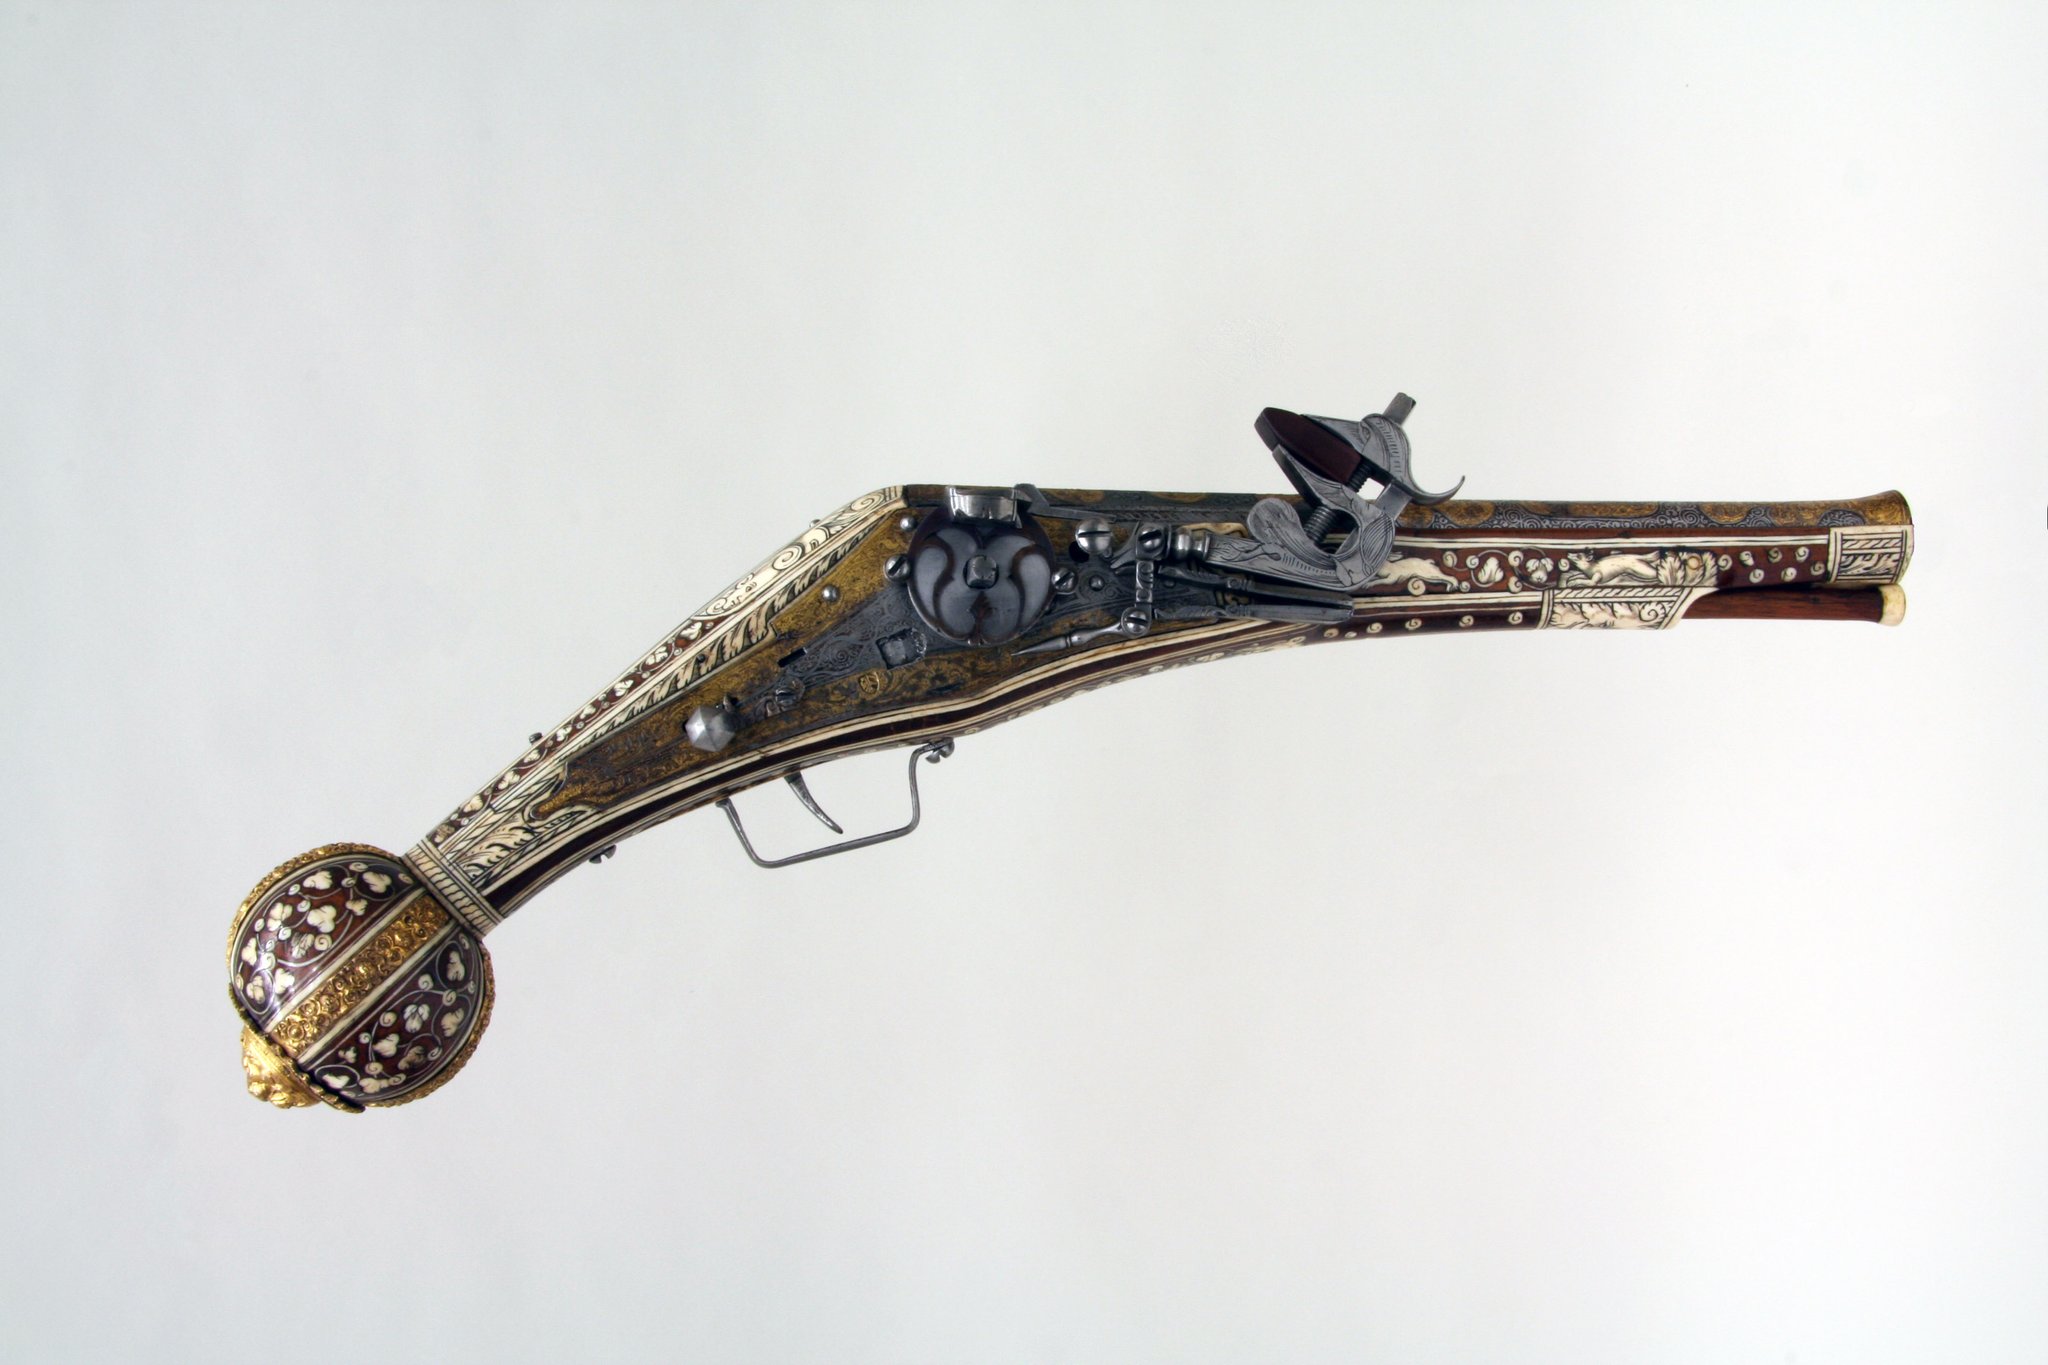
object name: wheellock pistol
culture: german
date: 1580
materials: bone, copper, gold, steel, wood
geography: germany